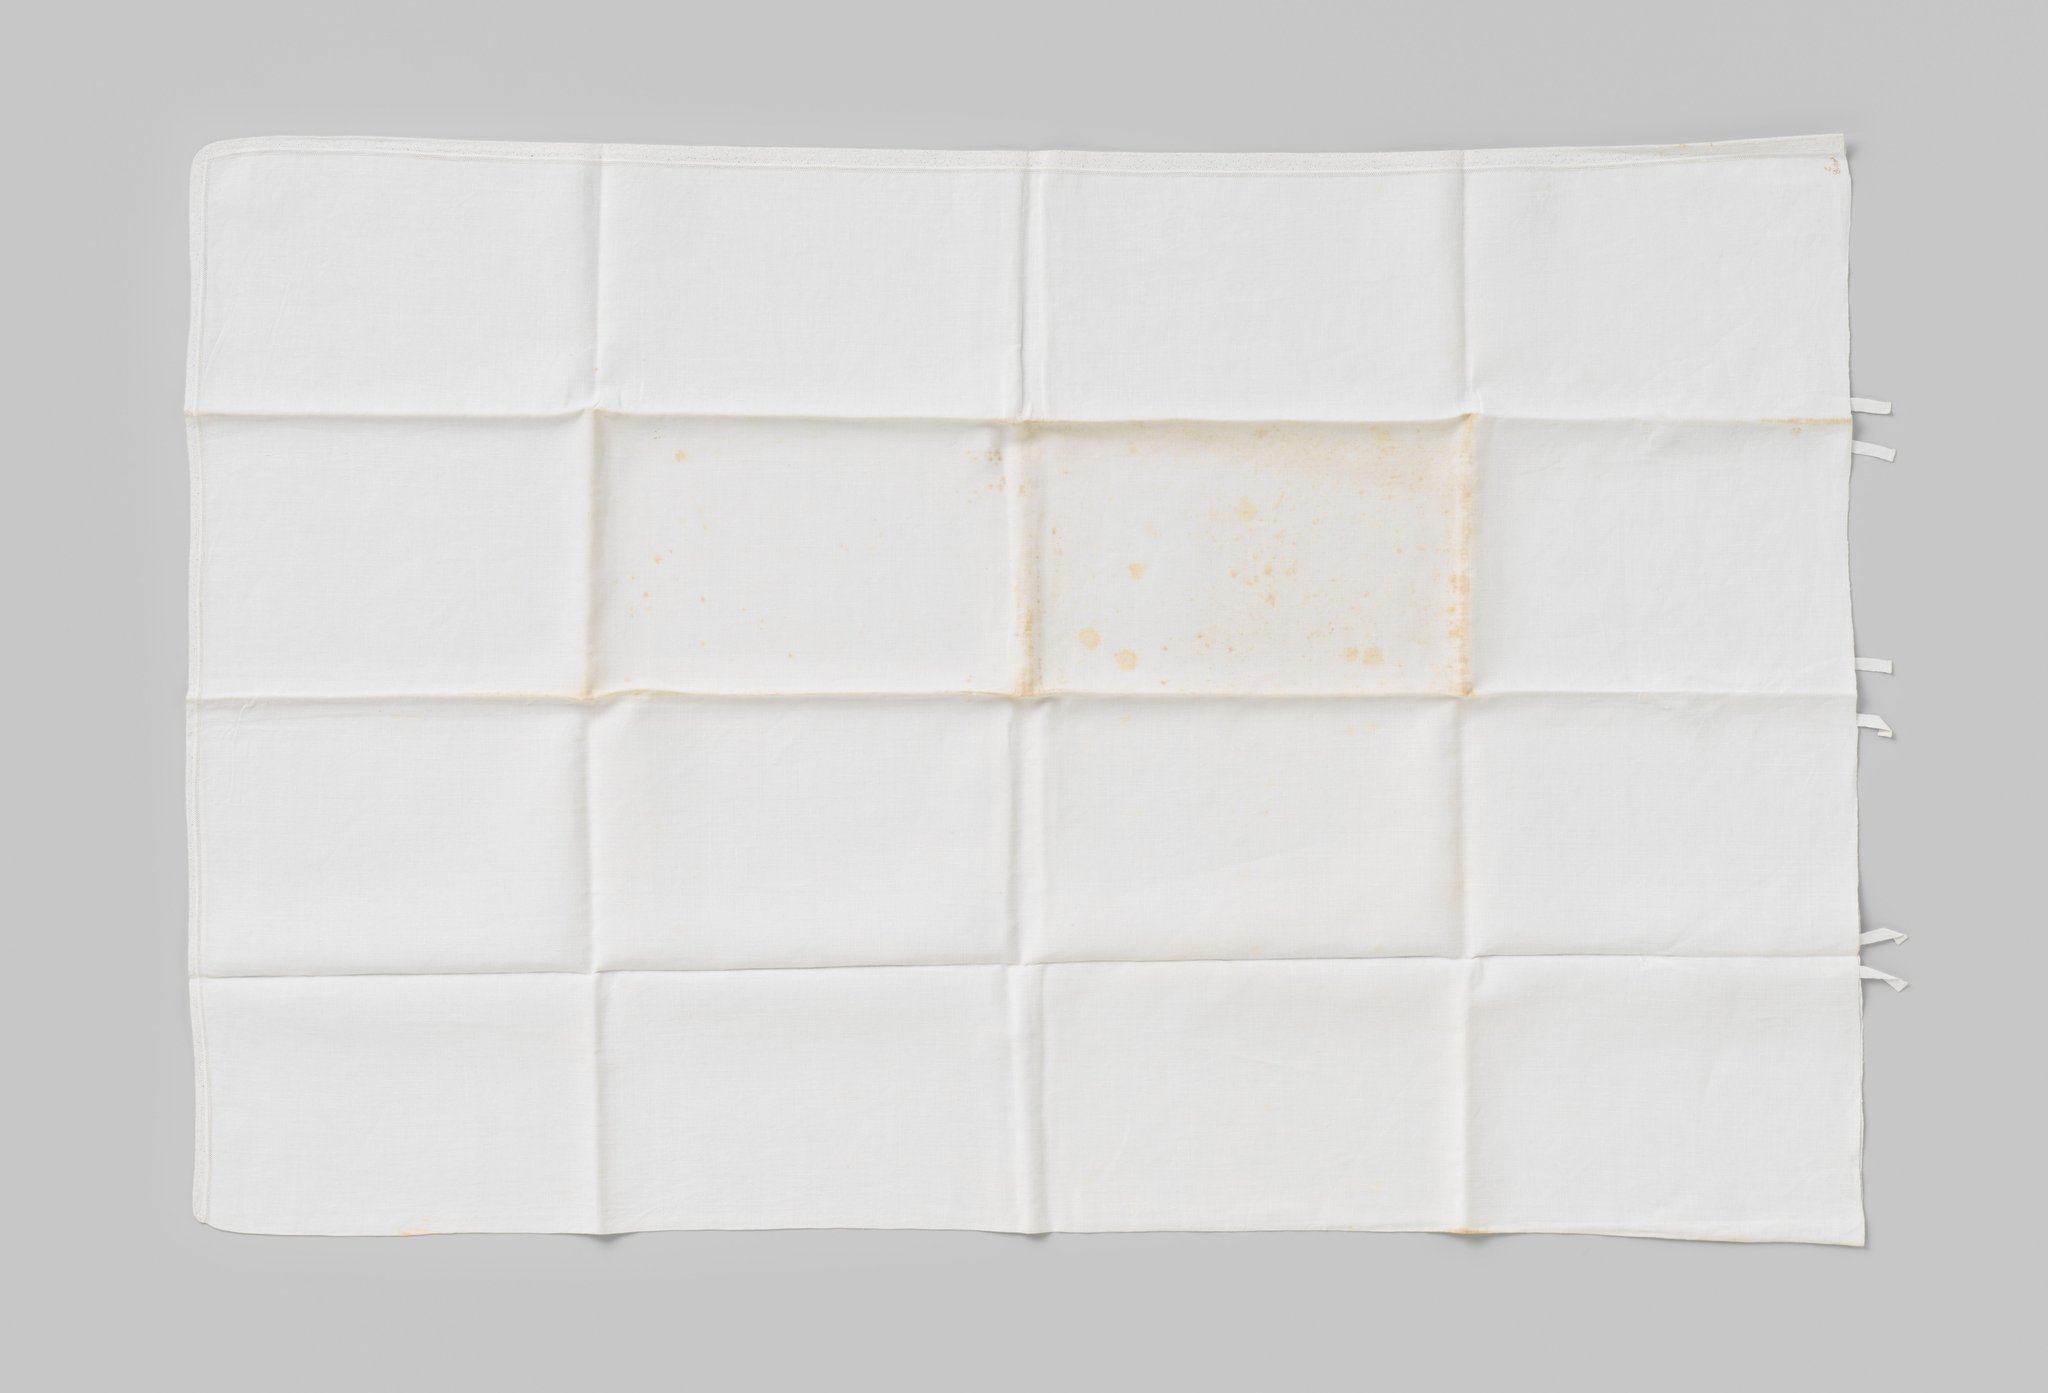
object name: pillowcase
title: Kussensloop met tussenzetsel van kloskant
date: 1600-1799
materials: linen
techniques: lace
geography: netherlands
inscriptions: mark: ‘AvB2’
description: Twee kussenslopen (BK-1994-27-A en B) met tussenzetsel van kloskant en geborduurd in bruin met resp. AvB2 en AvB3.